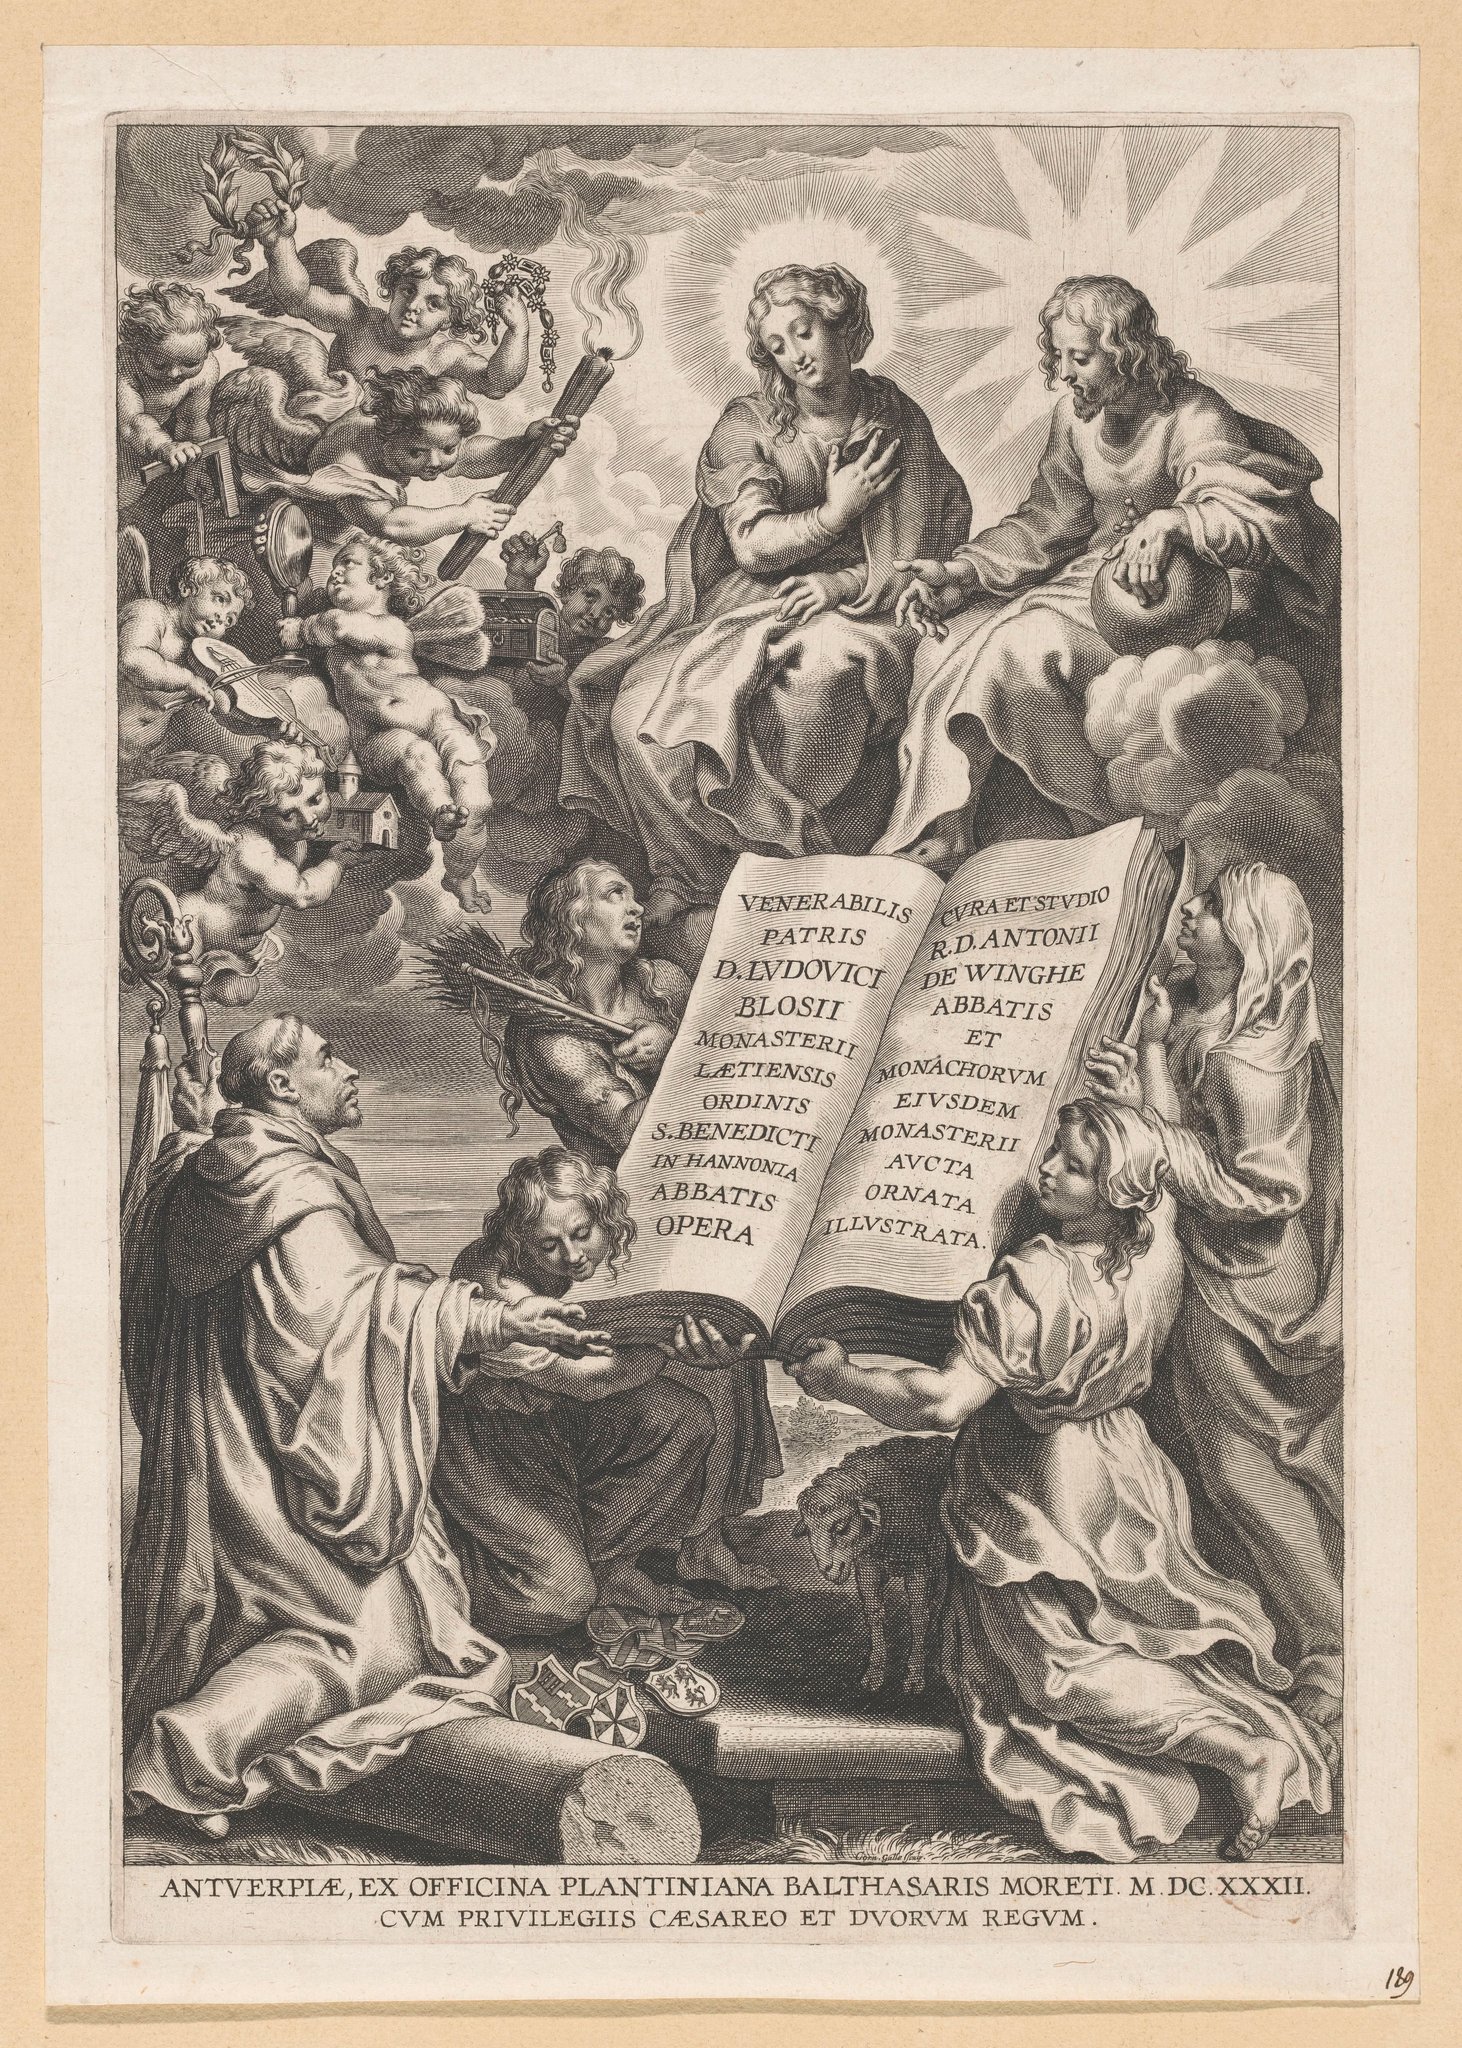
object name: titelblad, titelpagina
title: Ludovicus Blosius knielt voor Christus en Maria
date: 1632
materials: paper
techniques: engraving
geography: southern netherlands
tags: title-page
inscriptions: collector's mark: Lugt 240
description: De abt Ludovicus Blosius knielt op een zuil en biedt zijn boek aan Christus en Maria aan. Het boek wordt gedragen door de personificaties van de monastieke deugden. Op de grond ligt een ketting met wapens, waarvan het eerste het familiewapen van Blosius is. Linksboven een groep engelen met attributen die verband houden met de inhoud van het boek.